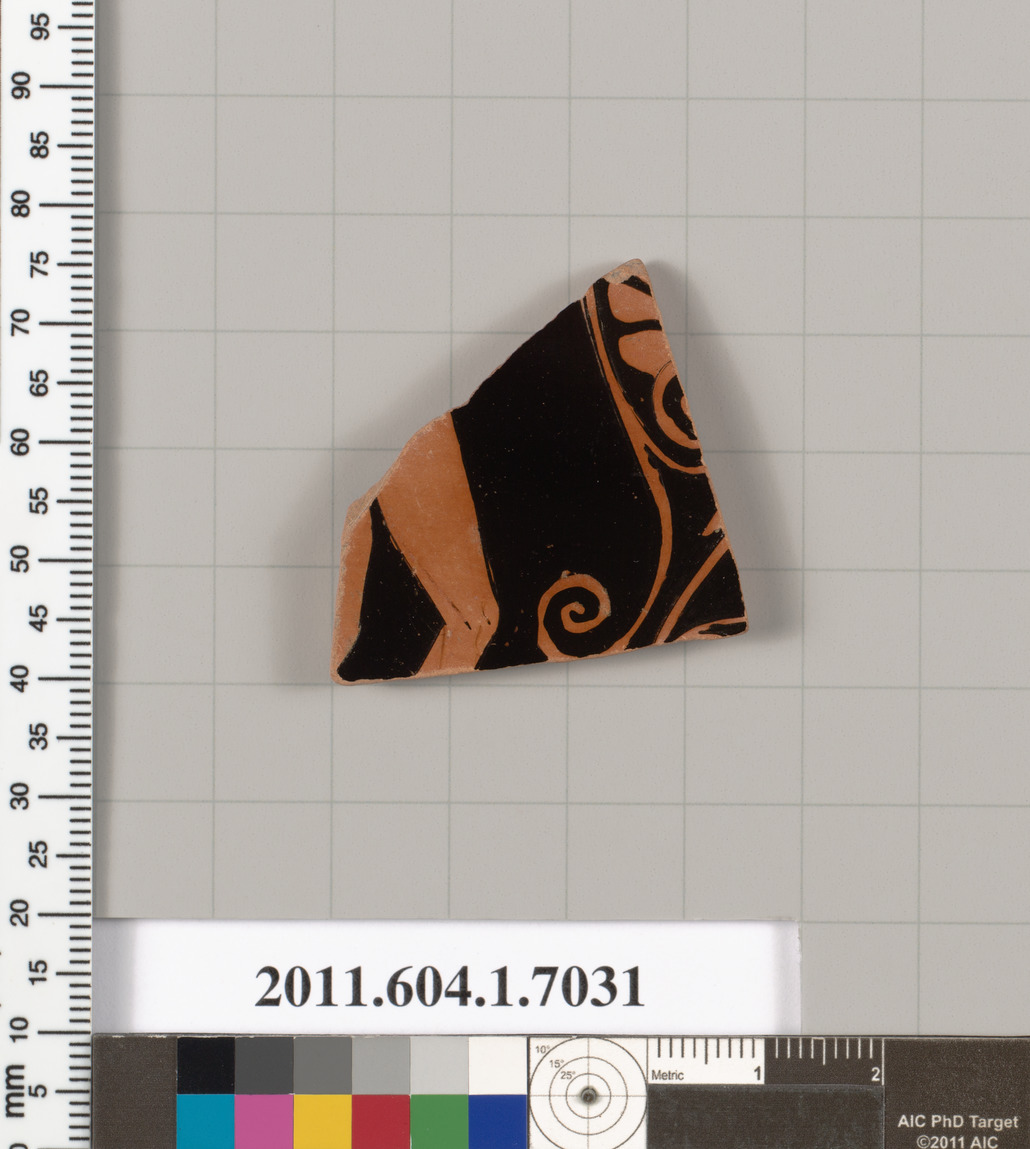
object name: kylix fragment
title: Terracotta fragment of a kylix (drinking cup)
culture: greek, attic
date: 500-480 BCE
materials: terracotta